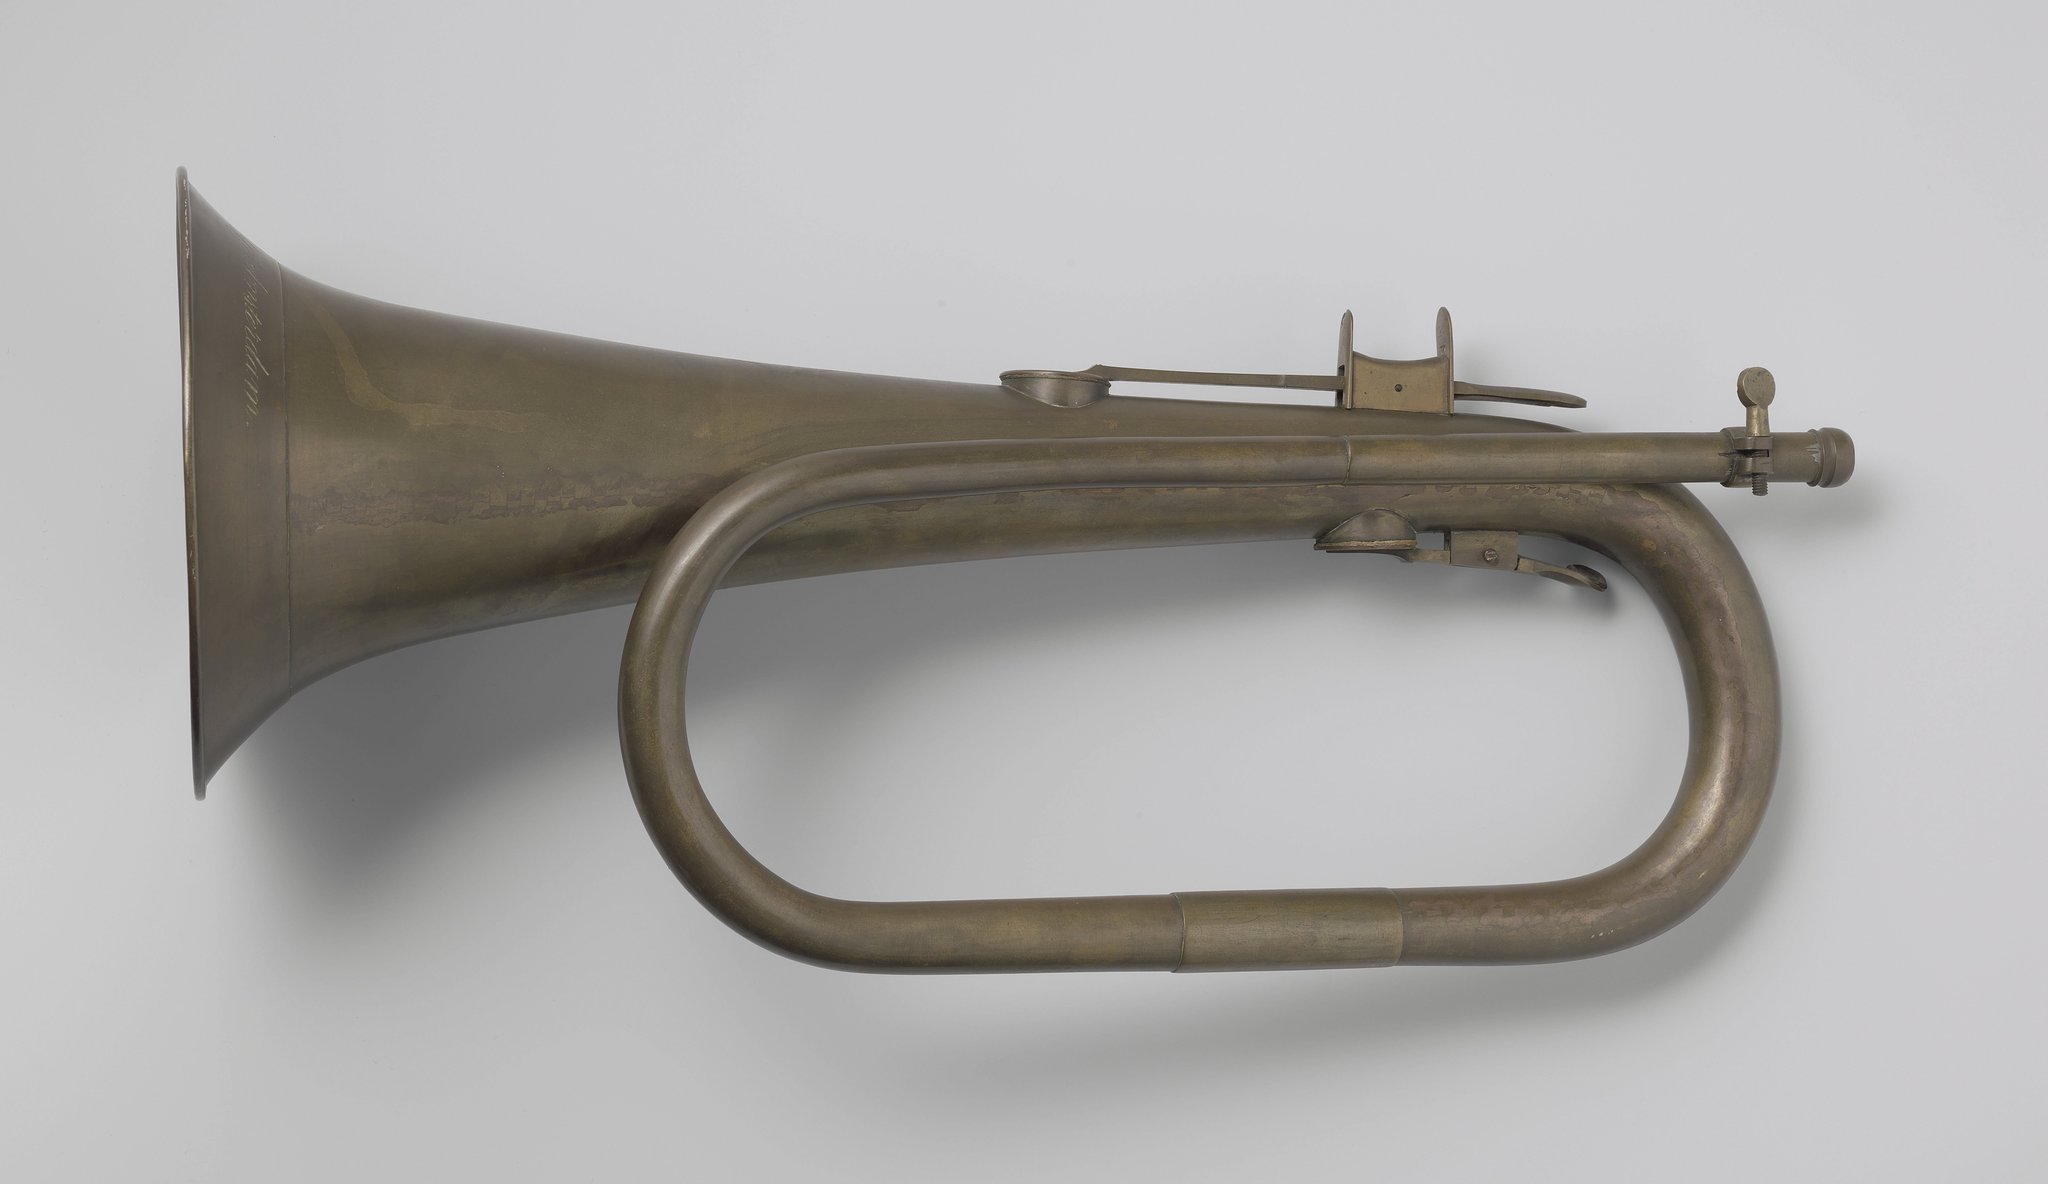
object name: musical instrument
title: Keyed bugle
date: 1830-1840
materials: brass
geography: amsterdam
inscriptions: inscription: ‘L. Embach & Co Amsterdam’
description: Kleppenbugel in Des met twee platte, ronde kleppen. Met steunzadel voor de middelfinger van rechterhand. De toets van de onderste klep loopt hieronder door. Mondstuk ontbreekt.